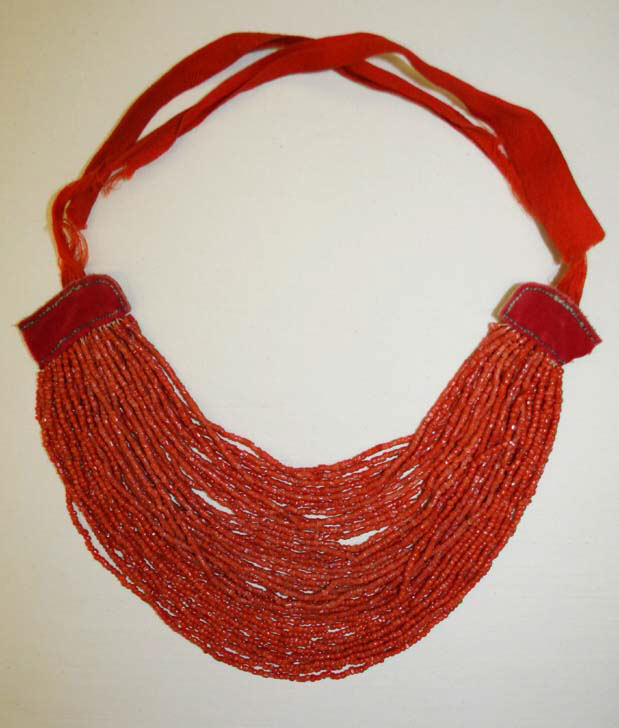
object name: necklace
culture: european, eastern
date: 1801-1900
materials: coral